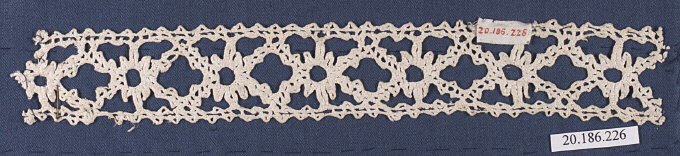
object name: insertion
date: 1501-1600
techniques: lace